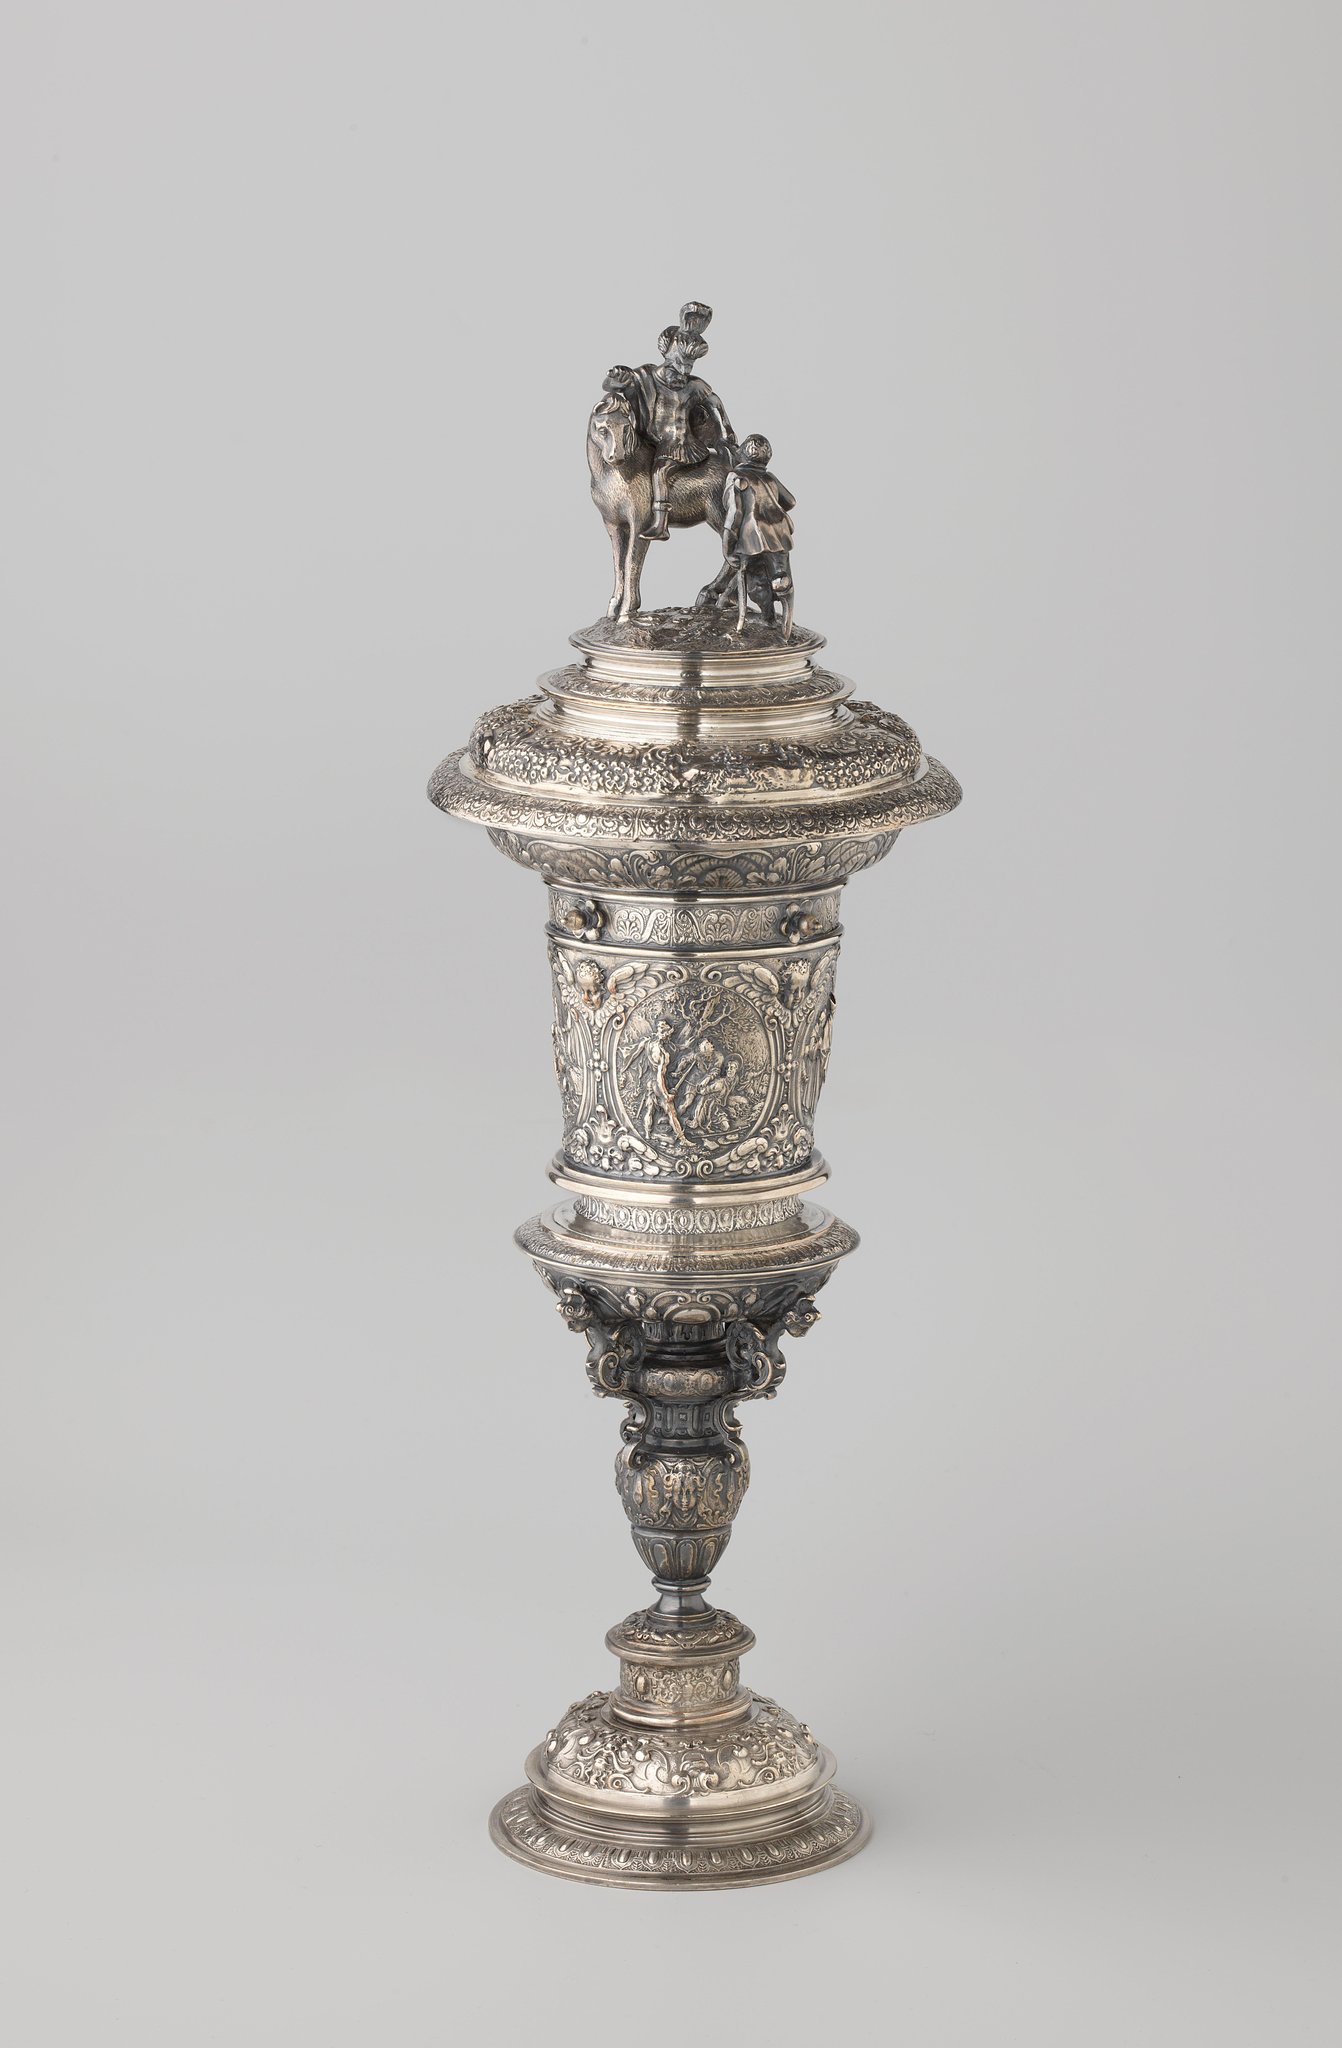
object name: cup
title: Galvanoplastische reproductie van de beker van het St. Maartens- of brouwersgilde van Haarlem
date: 1881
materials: copper, silver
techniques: galvanoplasty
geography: netherlands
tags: haarlem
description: Galvanoplastische reproductie van de beker van het St. Maartens- of brouwersgilde van Haarlem. De met renaissance-ornamenten versierde beker bestaat uit een cuppa, die geplaatst is op een voet met een balustervormige stam en vier voluten, welke in vrouwenkopjes eindigen. De bovenzijde van de cuppa heeft een verbrede rand, waarop een geprofileerd deksel rust met als bekroning een plastische groep, voorstellende Sint Maarten die zijn mantel in tweeën snijdt ten behoeve van een bedelaar. Het middenstuk draagt vier ovale medaillons, afgewisseld door gevleugelde engelenkopjes en andere motieven, die scenes uit het leven van de heilige weergeven. Men ziet hierop de bekering van een tweetal rovers, het opwekken van een jongen uit de dood, Sint Maarten bij de bouw van een kerk en zijn sterfbed. Op het gehele object zijn verschillende ornamentale versieringen aangebracht, die ondermeer uit bladmotieven, rolwerk, bloemguirlandes en satyrfiguren bestaan.